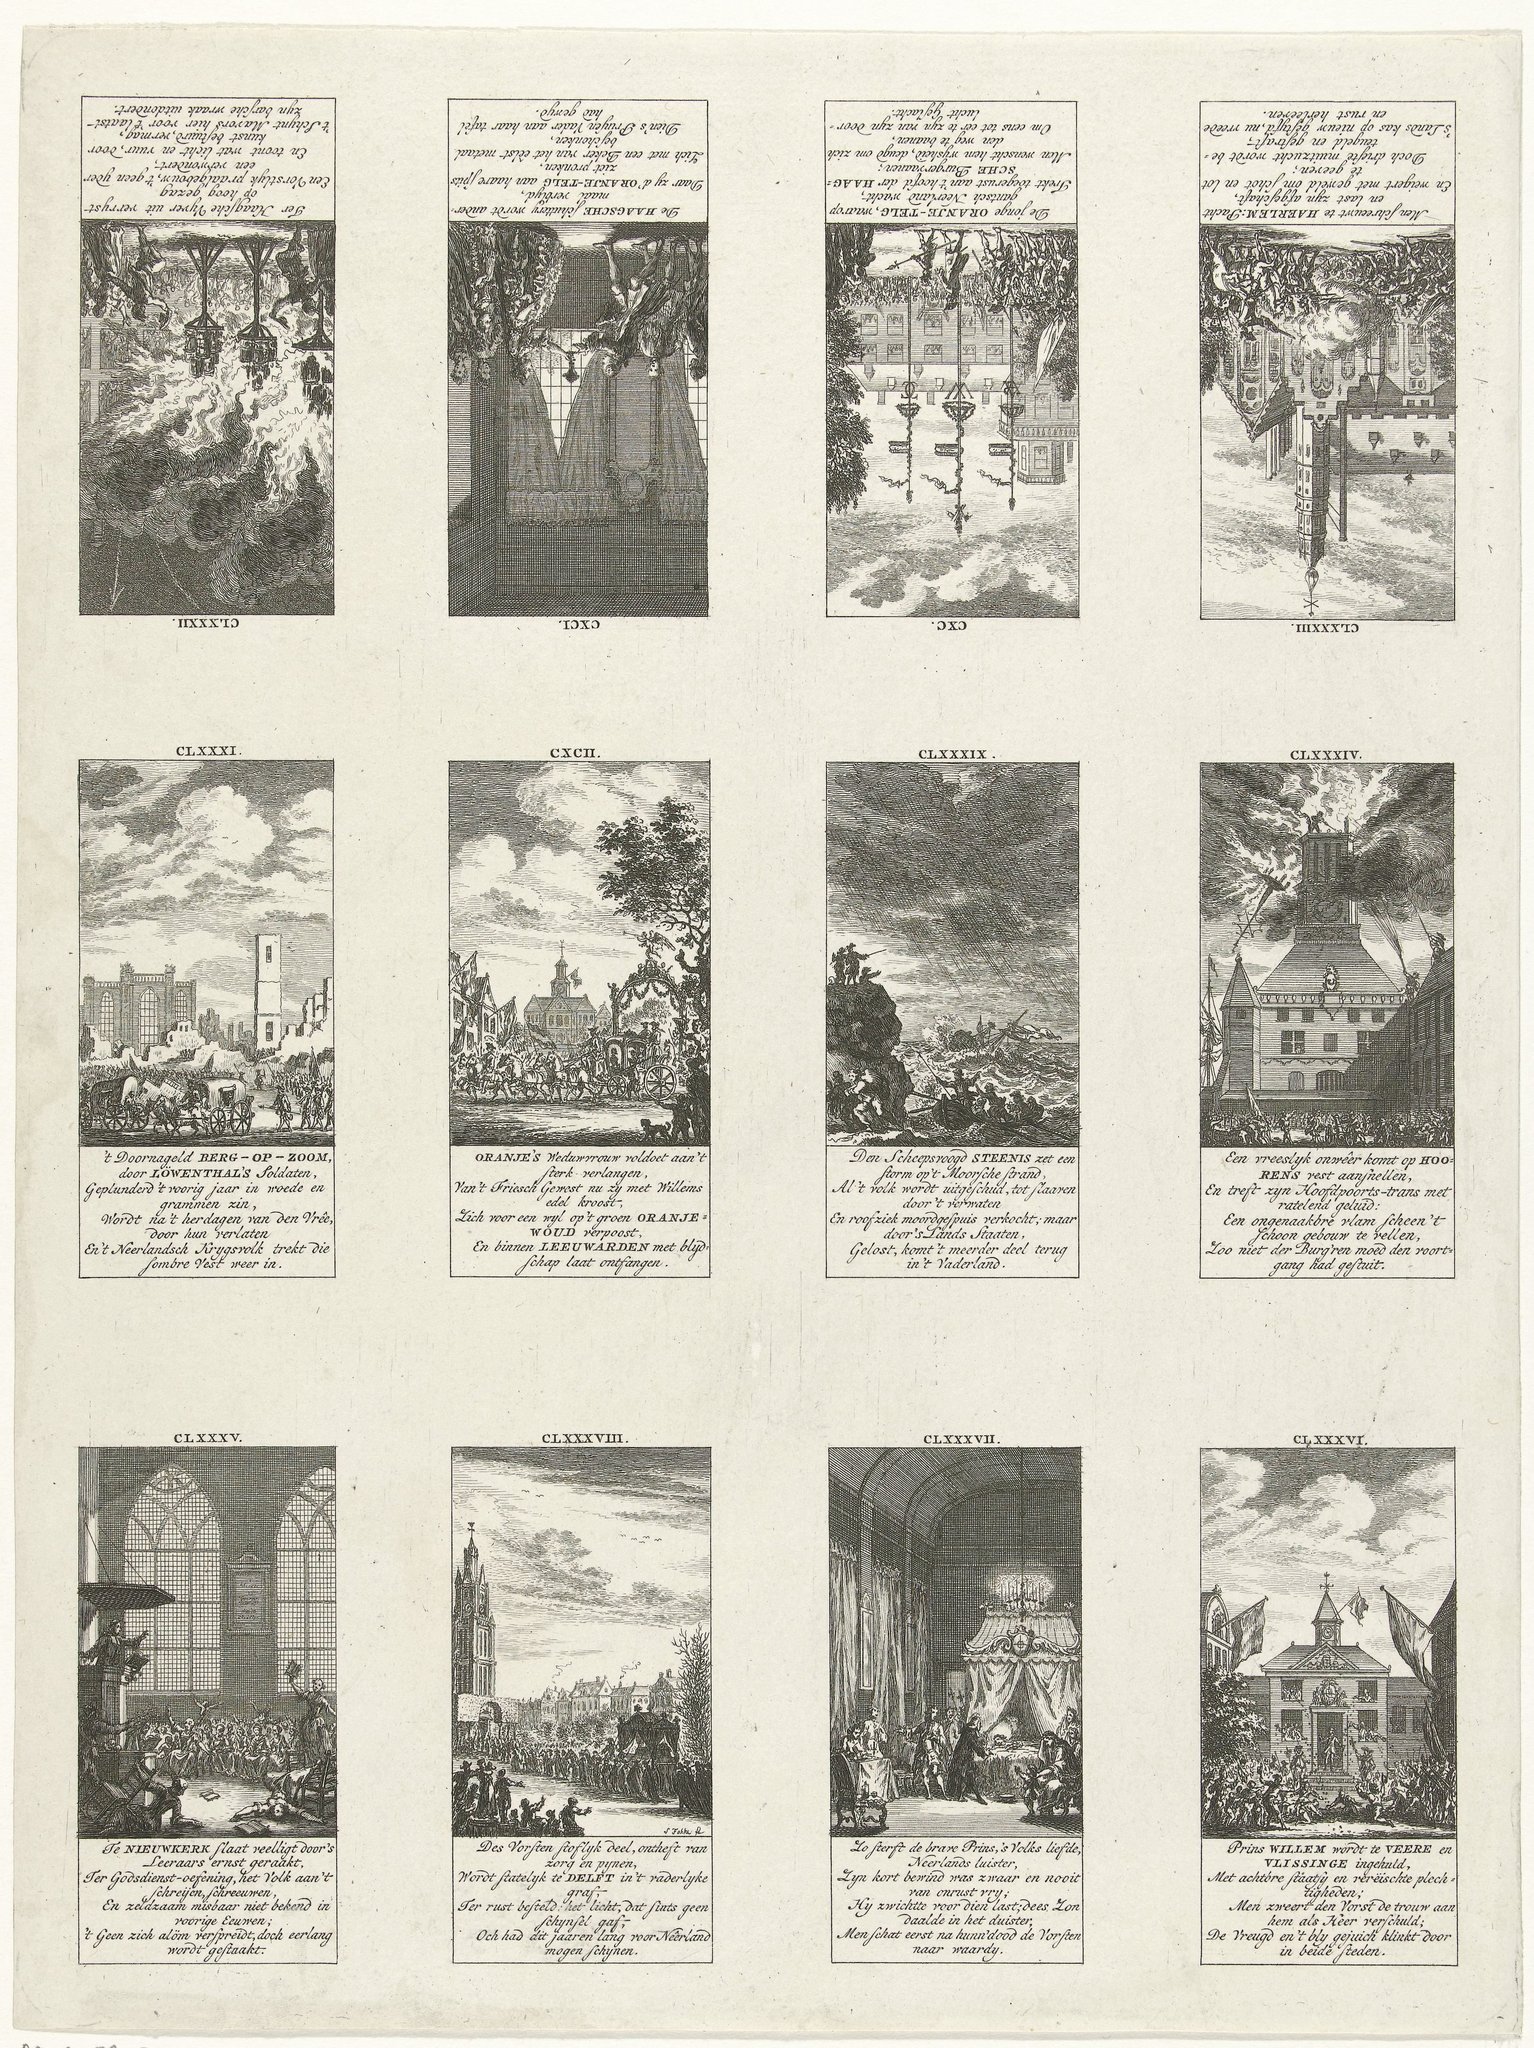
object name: print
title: Twaalf episodes uit de vaderlandse geschiedenis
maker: simon fokke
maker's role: draughtsman, print maker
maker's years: 1712-1784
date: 1722-1784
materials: paper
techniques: etching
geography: amsterdam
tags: historical events and situations, historical persons (portraits and scenes from the life)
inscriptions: collector's mark: Lugt 2228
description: Onversneden blad met twaalf voorstellingen uit de vaderlandse geschiedenis. De afbeeldingen zijn middenboven genummerd van CLXXXI tot en met CXCII en voorzien van toelichtende onderschriften.